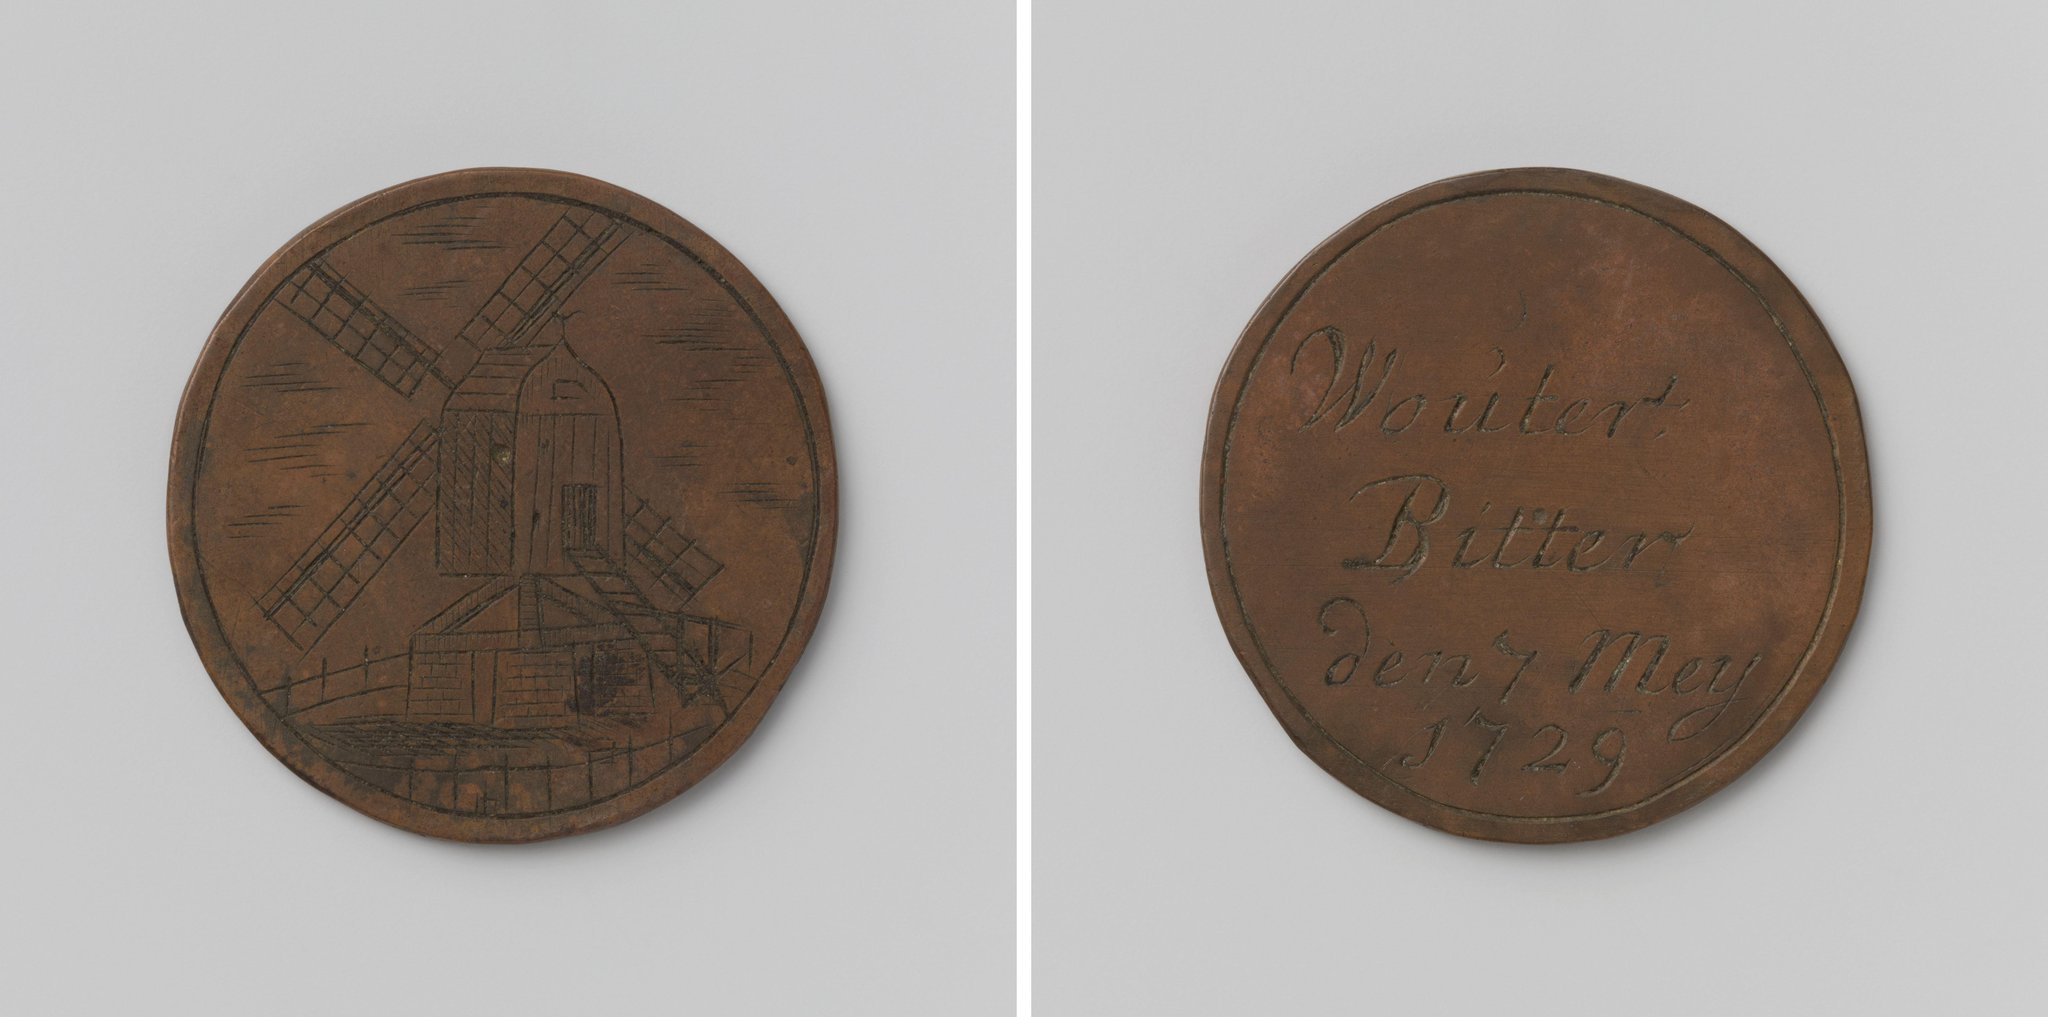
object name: medal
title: Korenmolenaarsgilde van Amsterdam, gildepenning van Wouter Bitter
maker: Anonymous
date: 1729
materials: copper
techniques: engraving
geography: amsterdam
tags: amsterdam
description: Koperen penning. Voorzijde: korenmolen. Keerzijde: opschrift